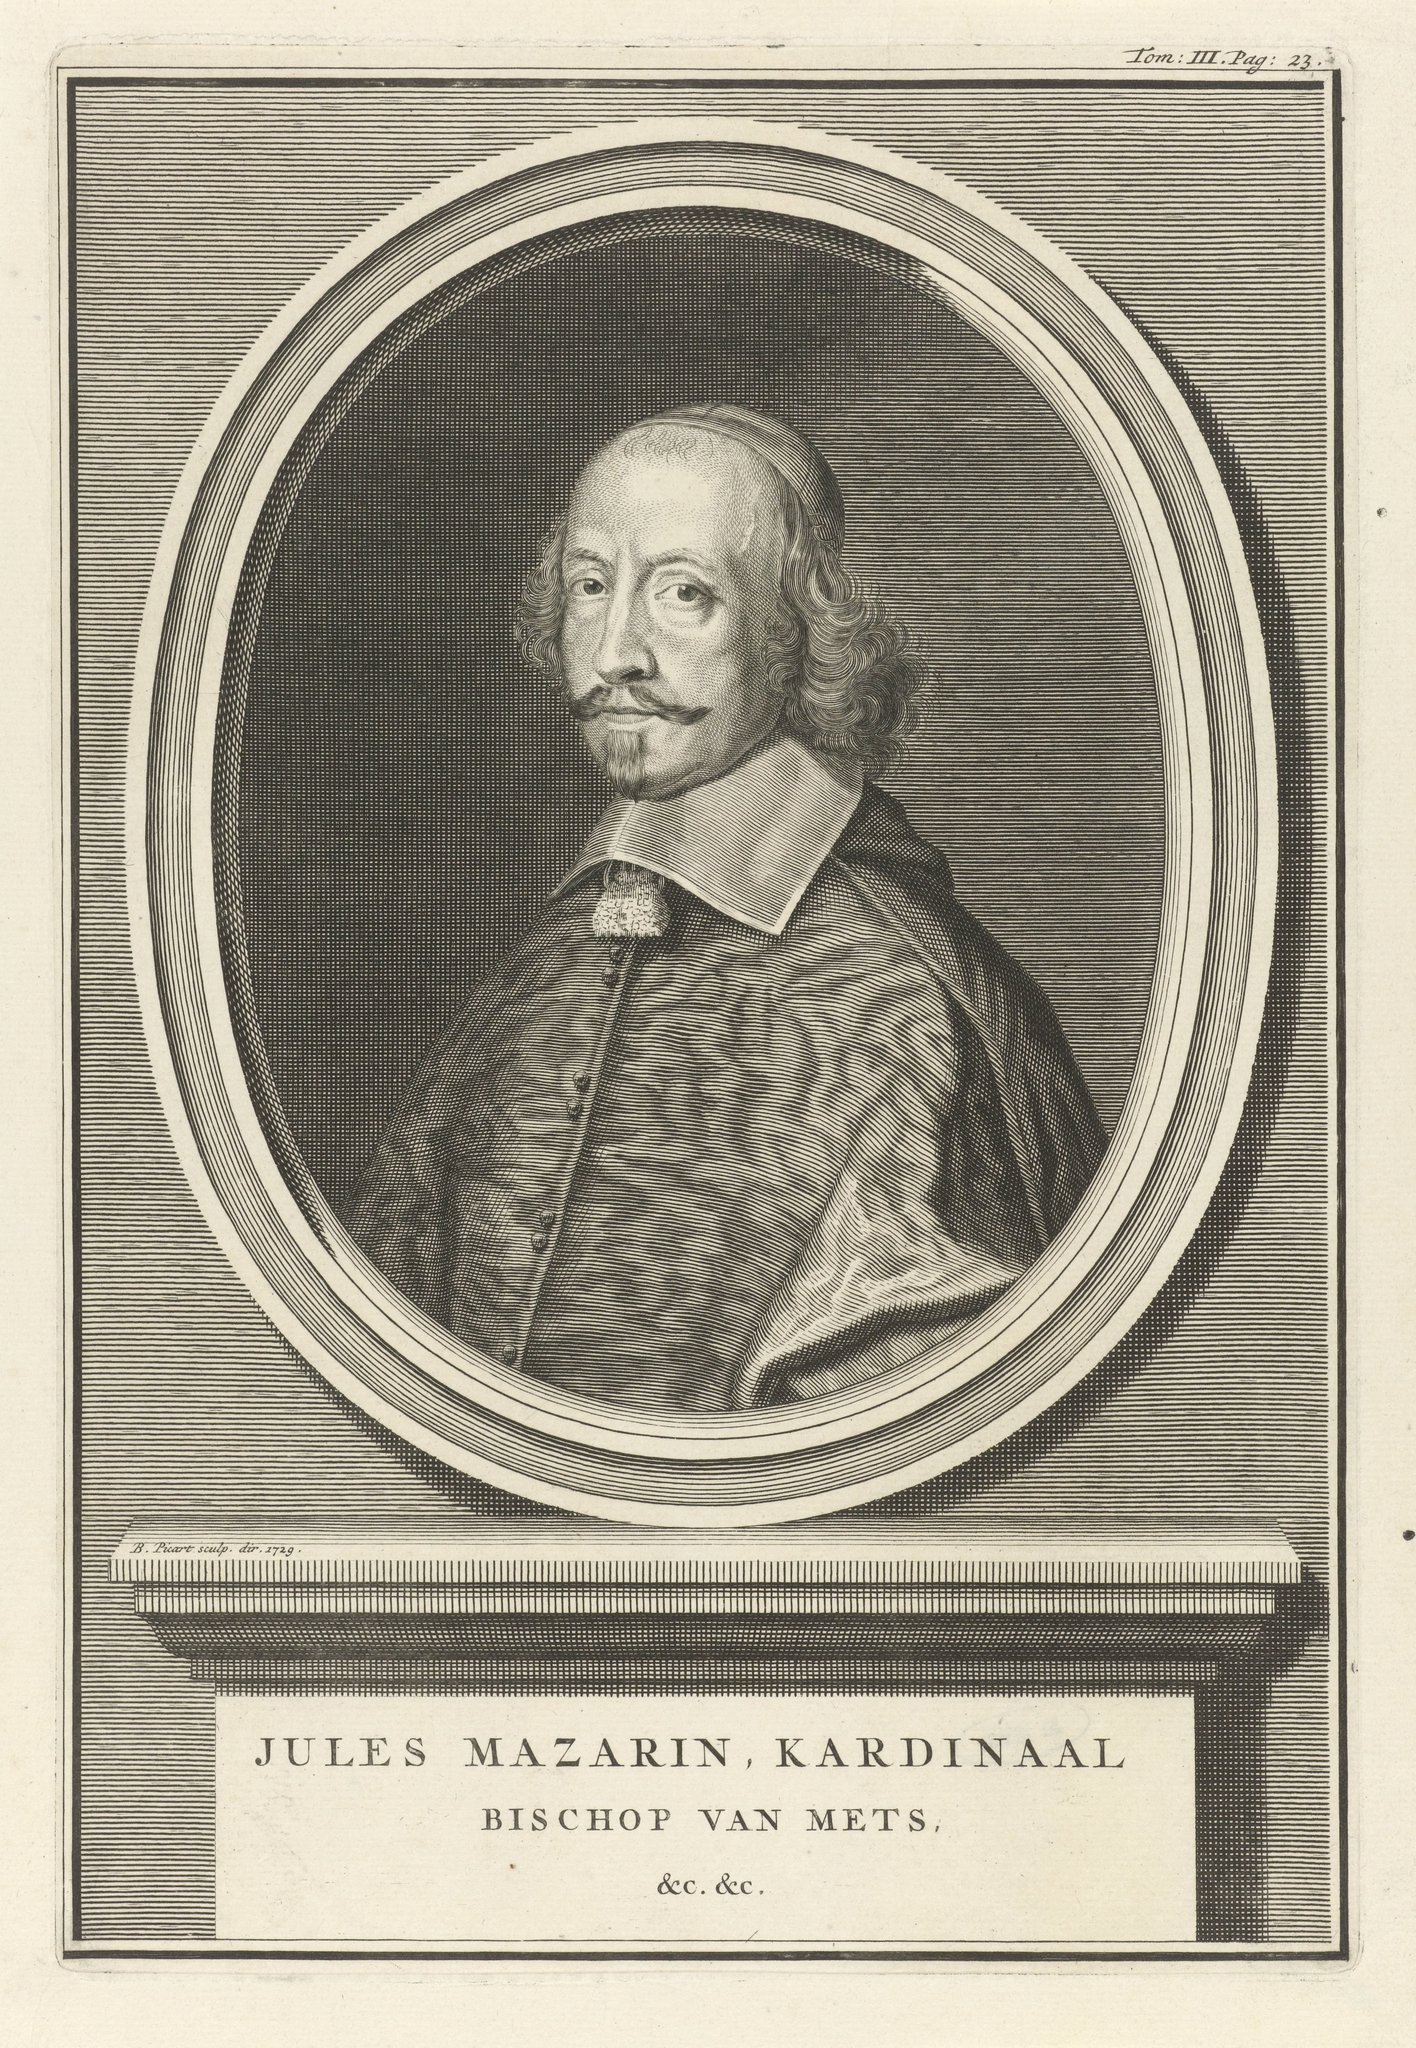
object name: print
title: Portret van kardinaal Jules Mazarin, bisschop van Metz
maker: bernard picart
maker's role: draughtsman, print maker, publisher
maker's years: 1673-1733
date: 1729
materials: paper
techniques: engraving, etching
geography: amsterdam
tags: cardinal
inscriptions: collector's mark: Lugt 2228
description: Prent als illustratie gebruikt in: Le Clerc, Jean. Geschiedenissen der Vereenigde Nederlanden. Amsterdam: Zacharias Chatelain (II), 1730.